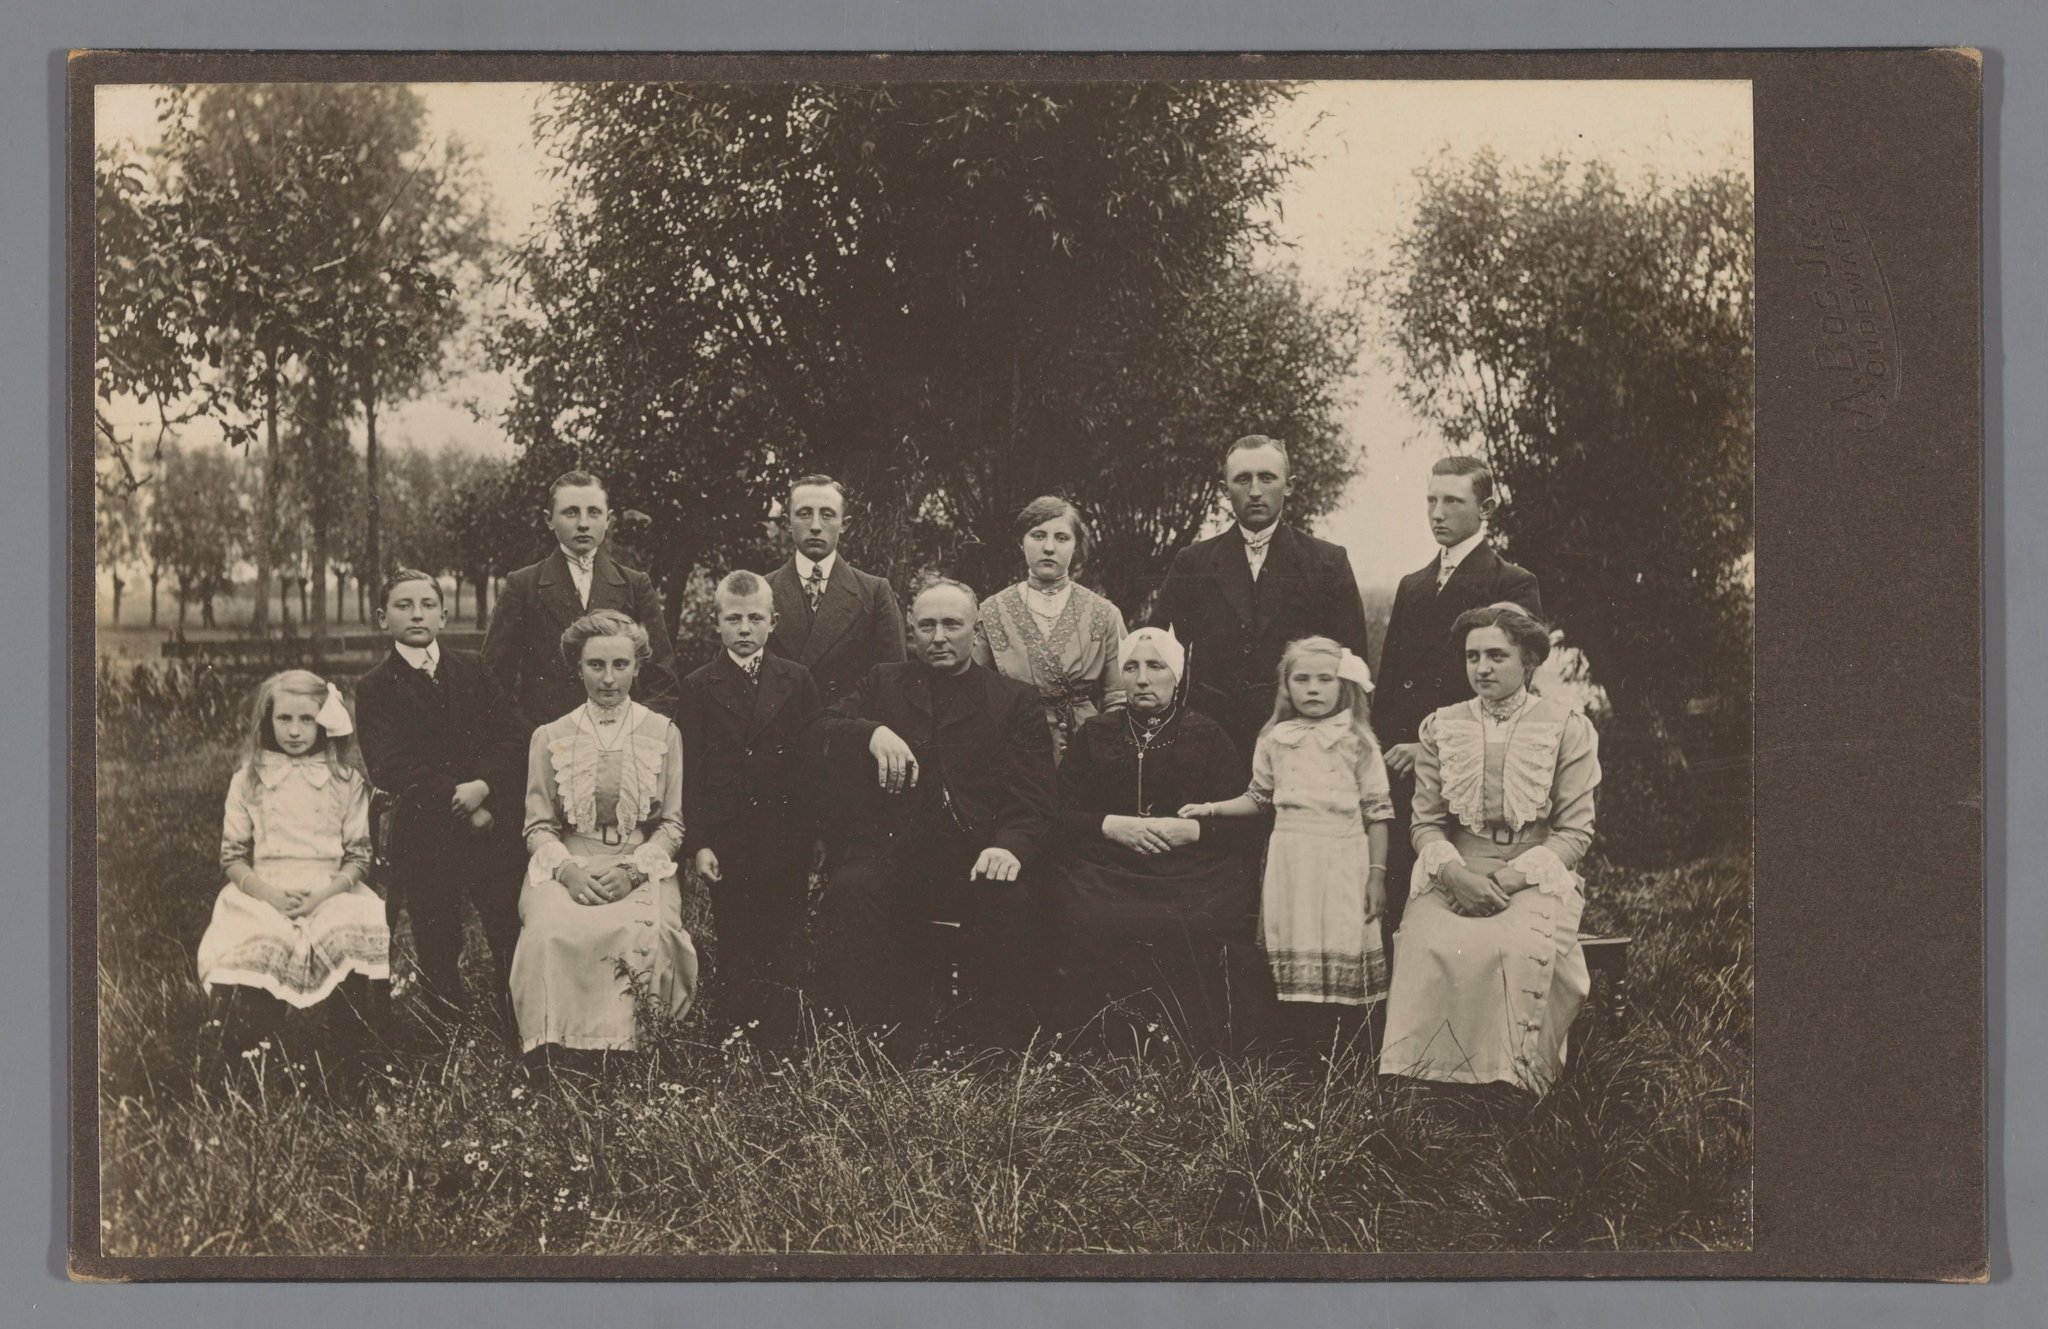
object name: cabinet photograph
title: Familieportret in een tuin voor bomen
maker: adriaan bos jr.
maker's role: fotograaf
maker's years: 1869-1940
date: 1893-1933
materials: cardboard, photographic support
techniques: gelatin silver print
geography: oudewater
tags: family, relationship, descent